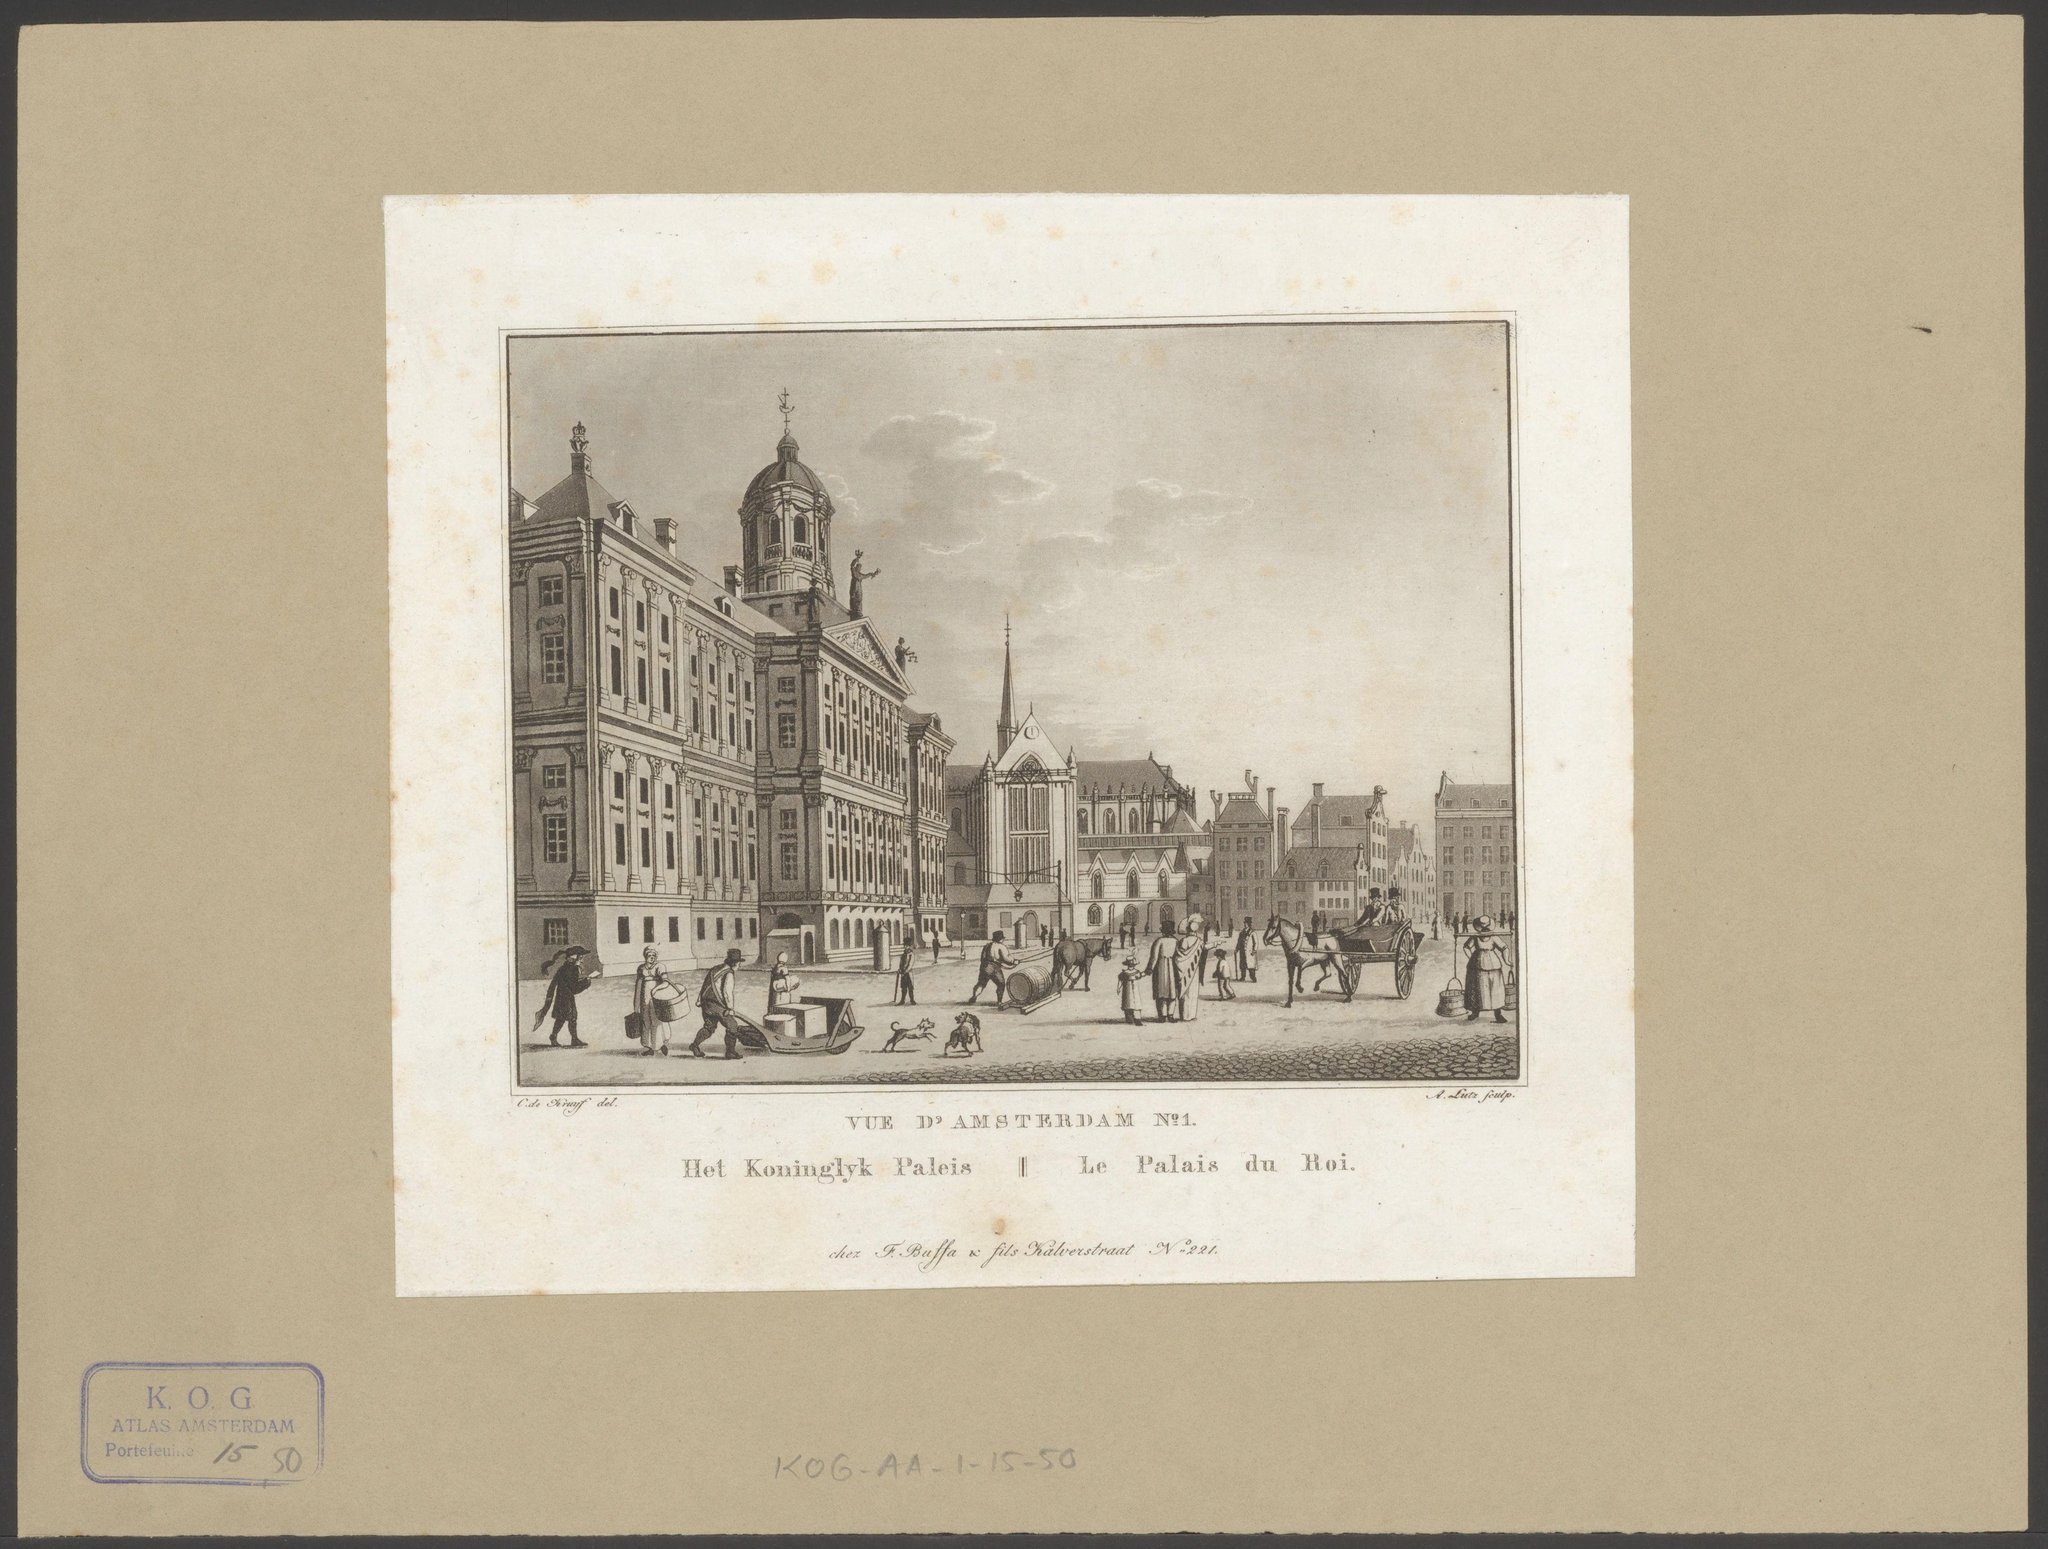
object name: print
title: Gezichten op Amsterdam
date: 1850-1899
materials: paper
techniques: aquatint, etching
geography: amsterdam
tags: square, place, circus, etc., city-view in general; 'veduta', church (exterior), townhall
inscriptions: collector's mark: ‘15,50’ Lugt 1641b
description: Onderwerpsrubriek binnen de Atlas Amsterdam: Nieuwe Stadhuis, als Paleis, op de Dam, van Buiten.